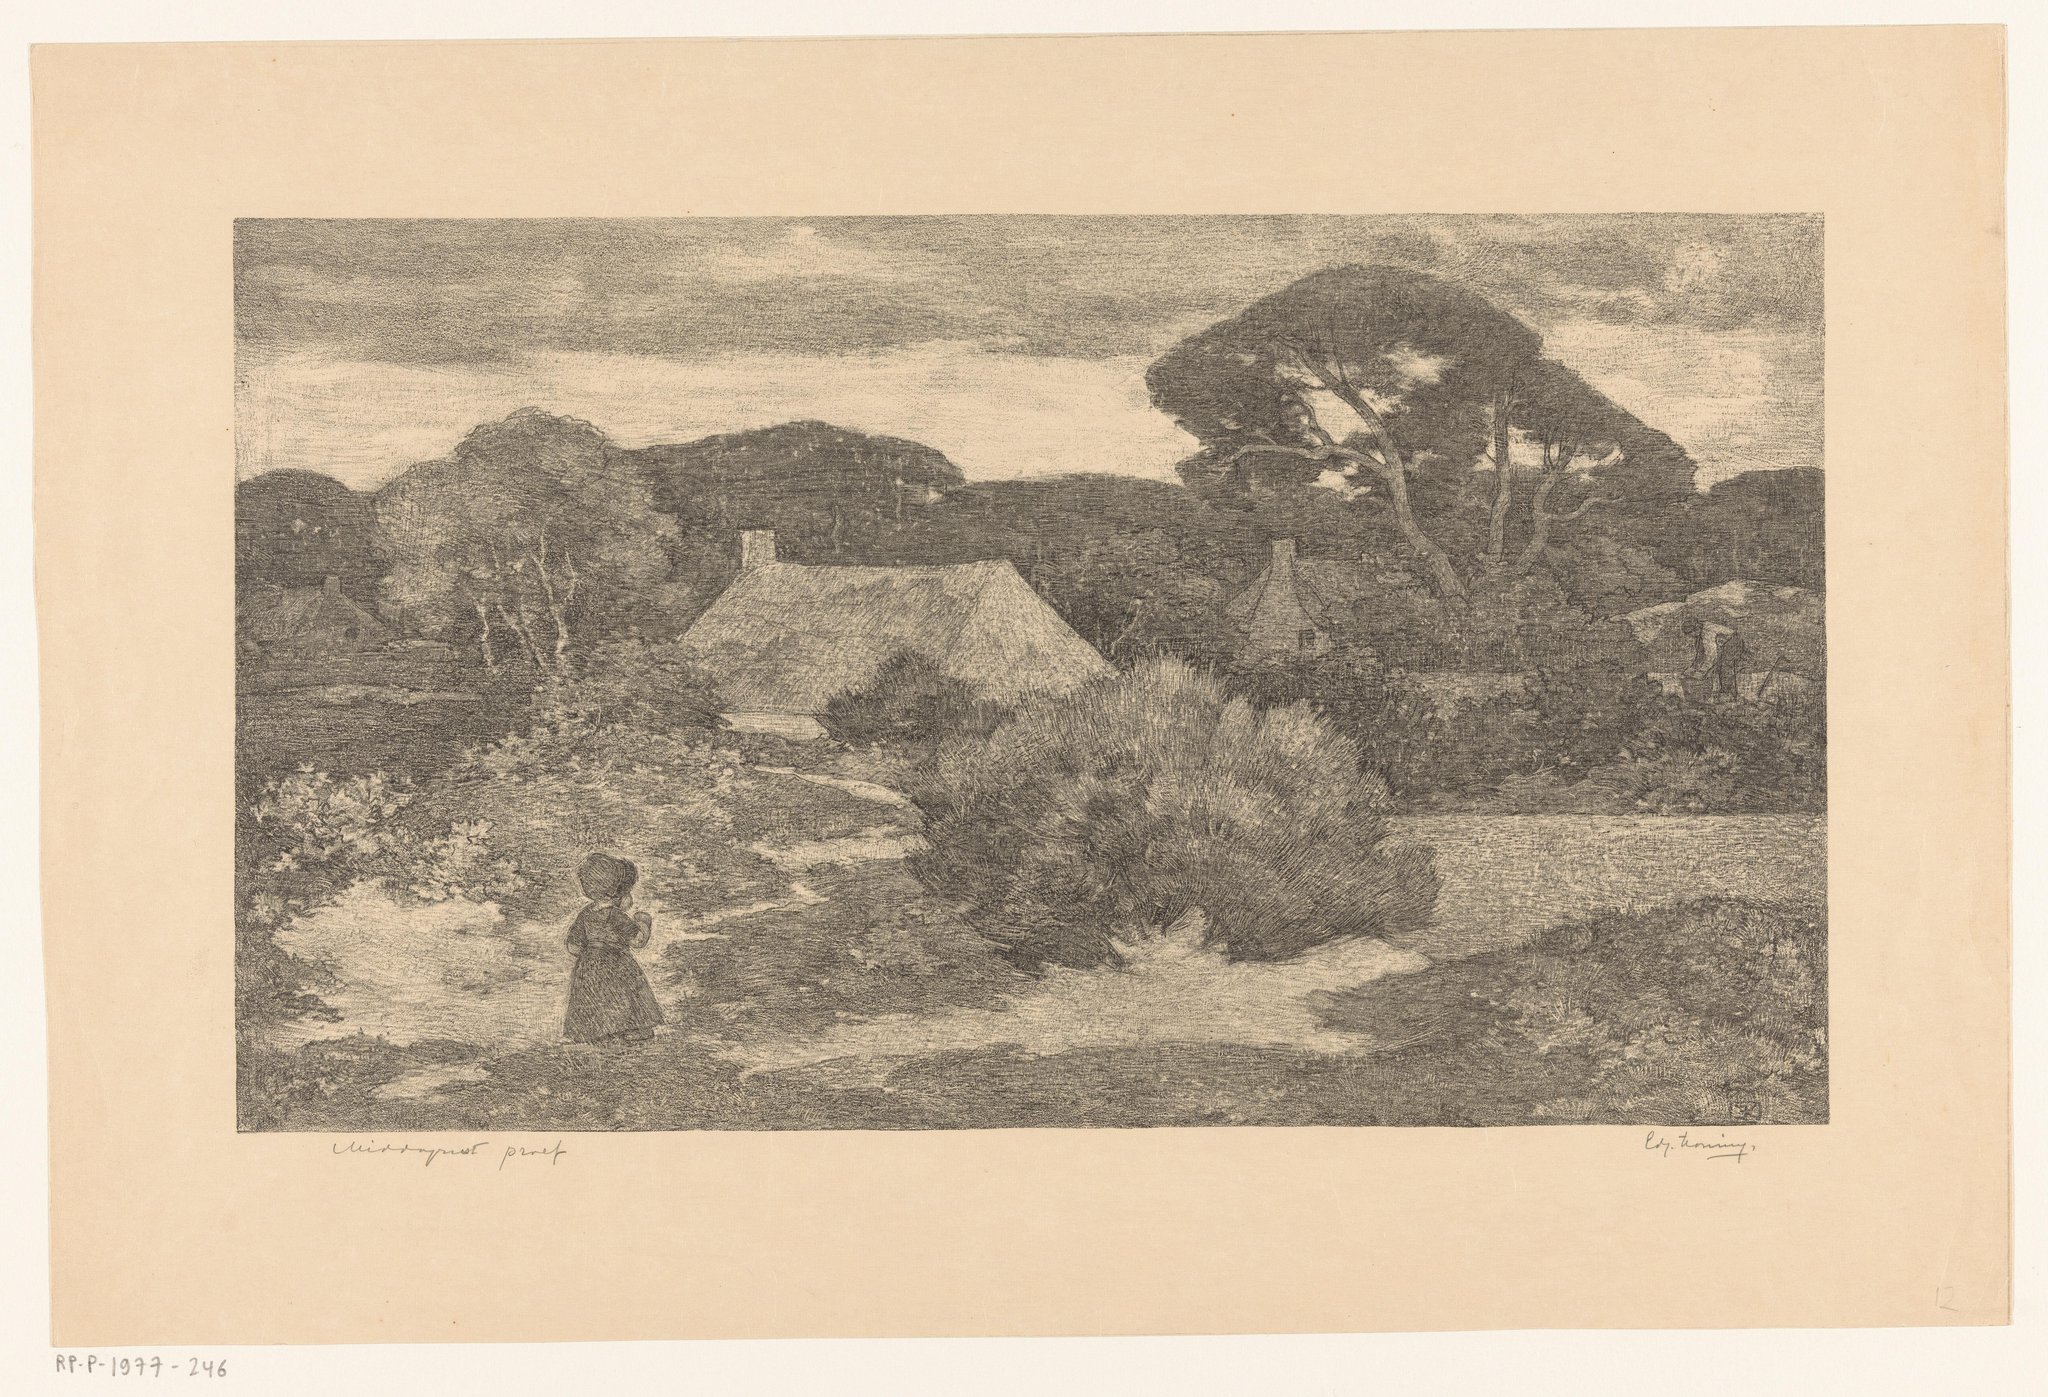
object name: print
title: Middagrust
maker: edzard koning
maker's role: draughtsman, print maker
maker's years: 1869-1954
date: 1879-1954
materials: paper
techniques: lithograph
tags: toddler, meadow, pasture, afternoon, farm or solitary house in landscape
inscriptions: collector's mark: Lugt 2760, collector's mark: Lugt 2228, number: ‘12’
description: Een heidelandschap met struiken, bomen en twee huizen. Op de voorgrond een wandelende peuter.